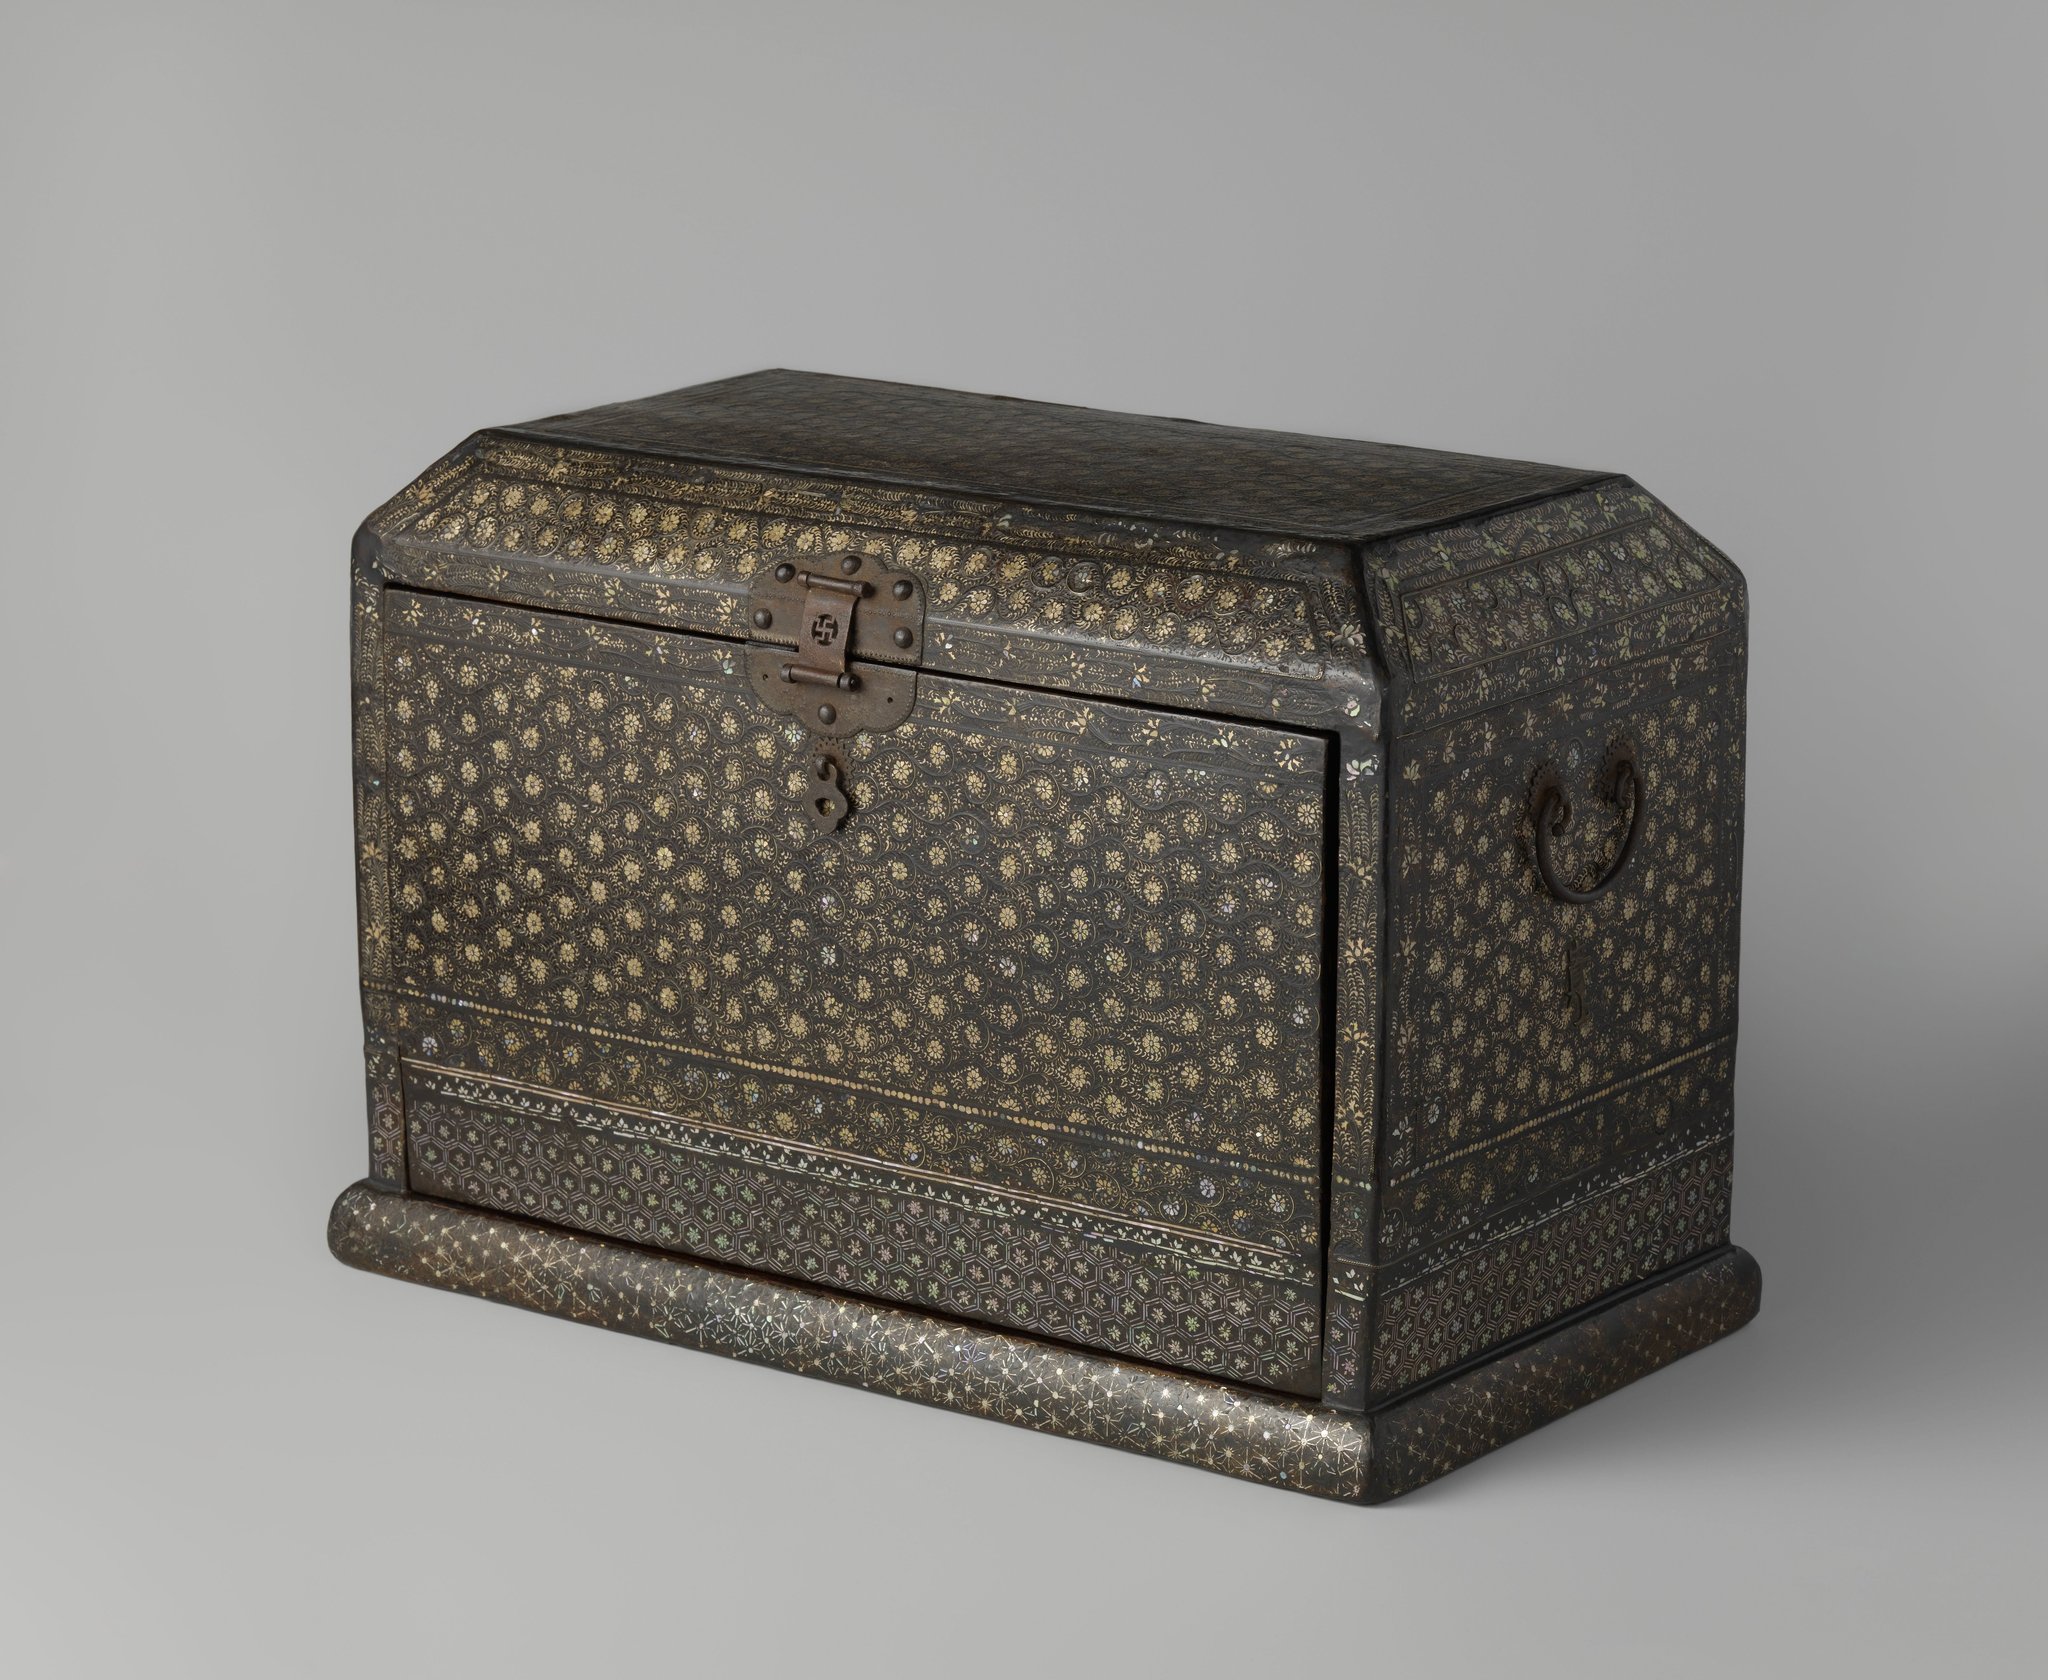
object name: box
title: Sutra box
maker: Anonymous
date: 1200-1400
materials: lacquer, mother of pearl, silver, wood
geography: korea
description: This box was used for storing sutras, Buddhist scriptures. Such boxes were made in court workshops. The whole surface is covered with mother-of-pearl and copper-wire inlay. However, the decoration of the lower section differs from the rest, suggesting that the box was repaired and enlarged. This may have been done in Japan, where the box was purchased in the early 20th century.